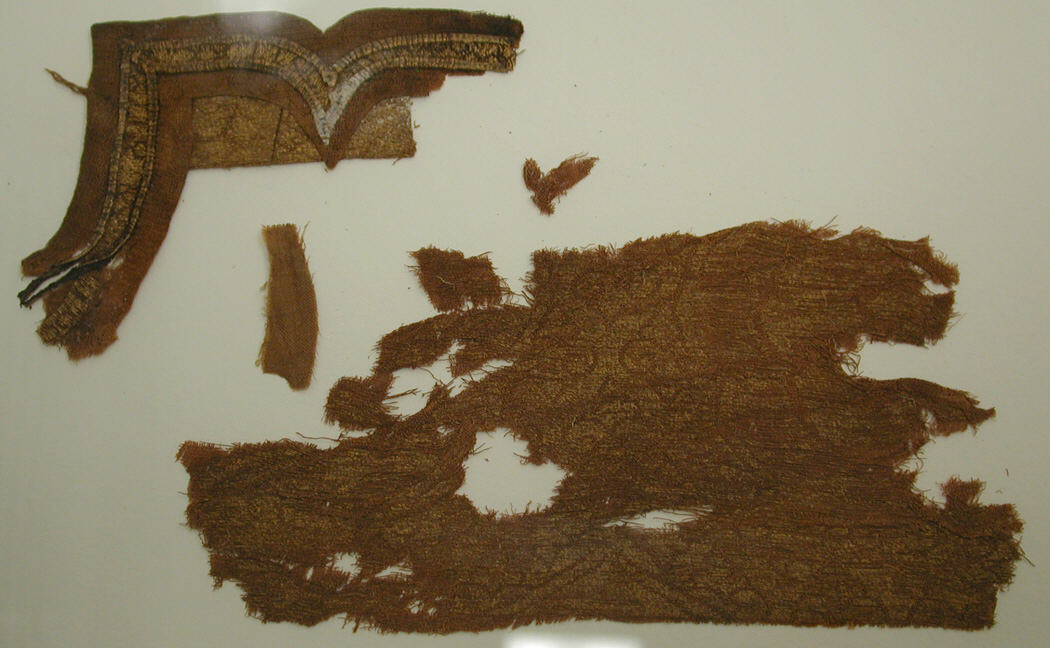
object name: cloth and border fragment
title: Cloth of Gold and Associated Border Fragments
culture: chinese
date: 1271-1368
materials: metal thread, silk